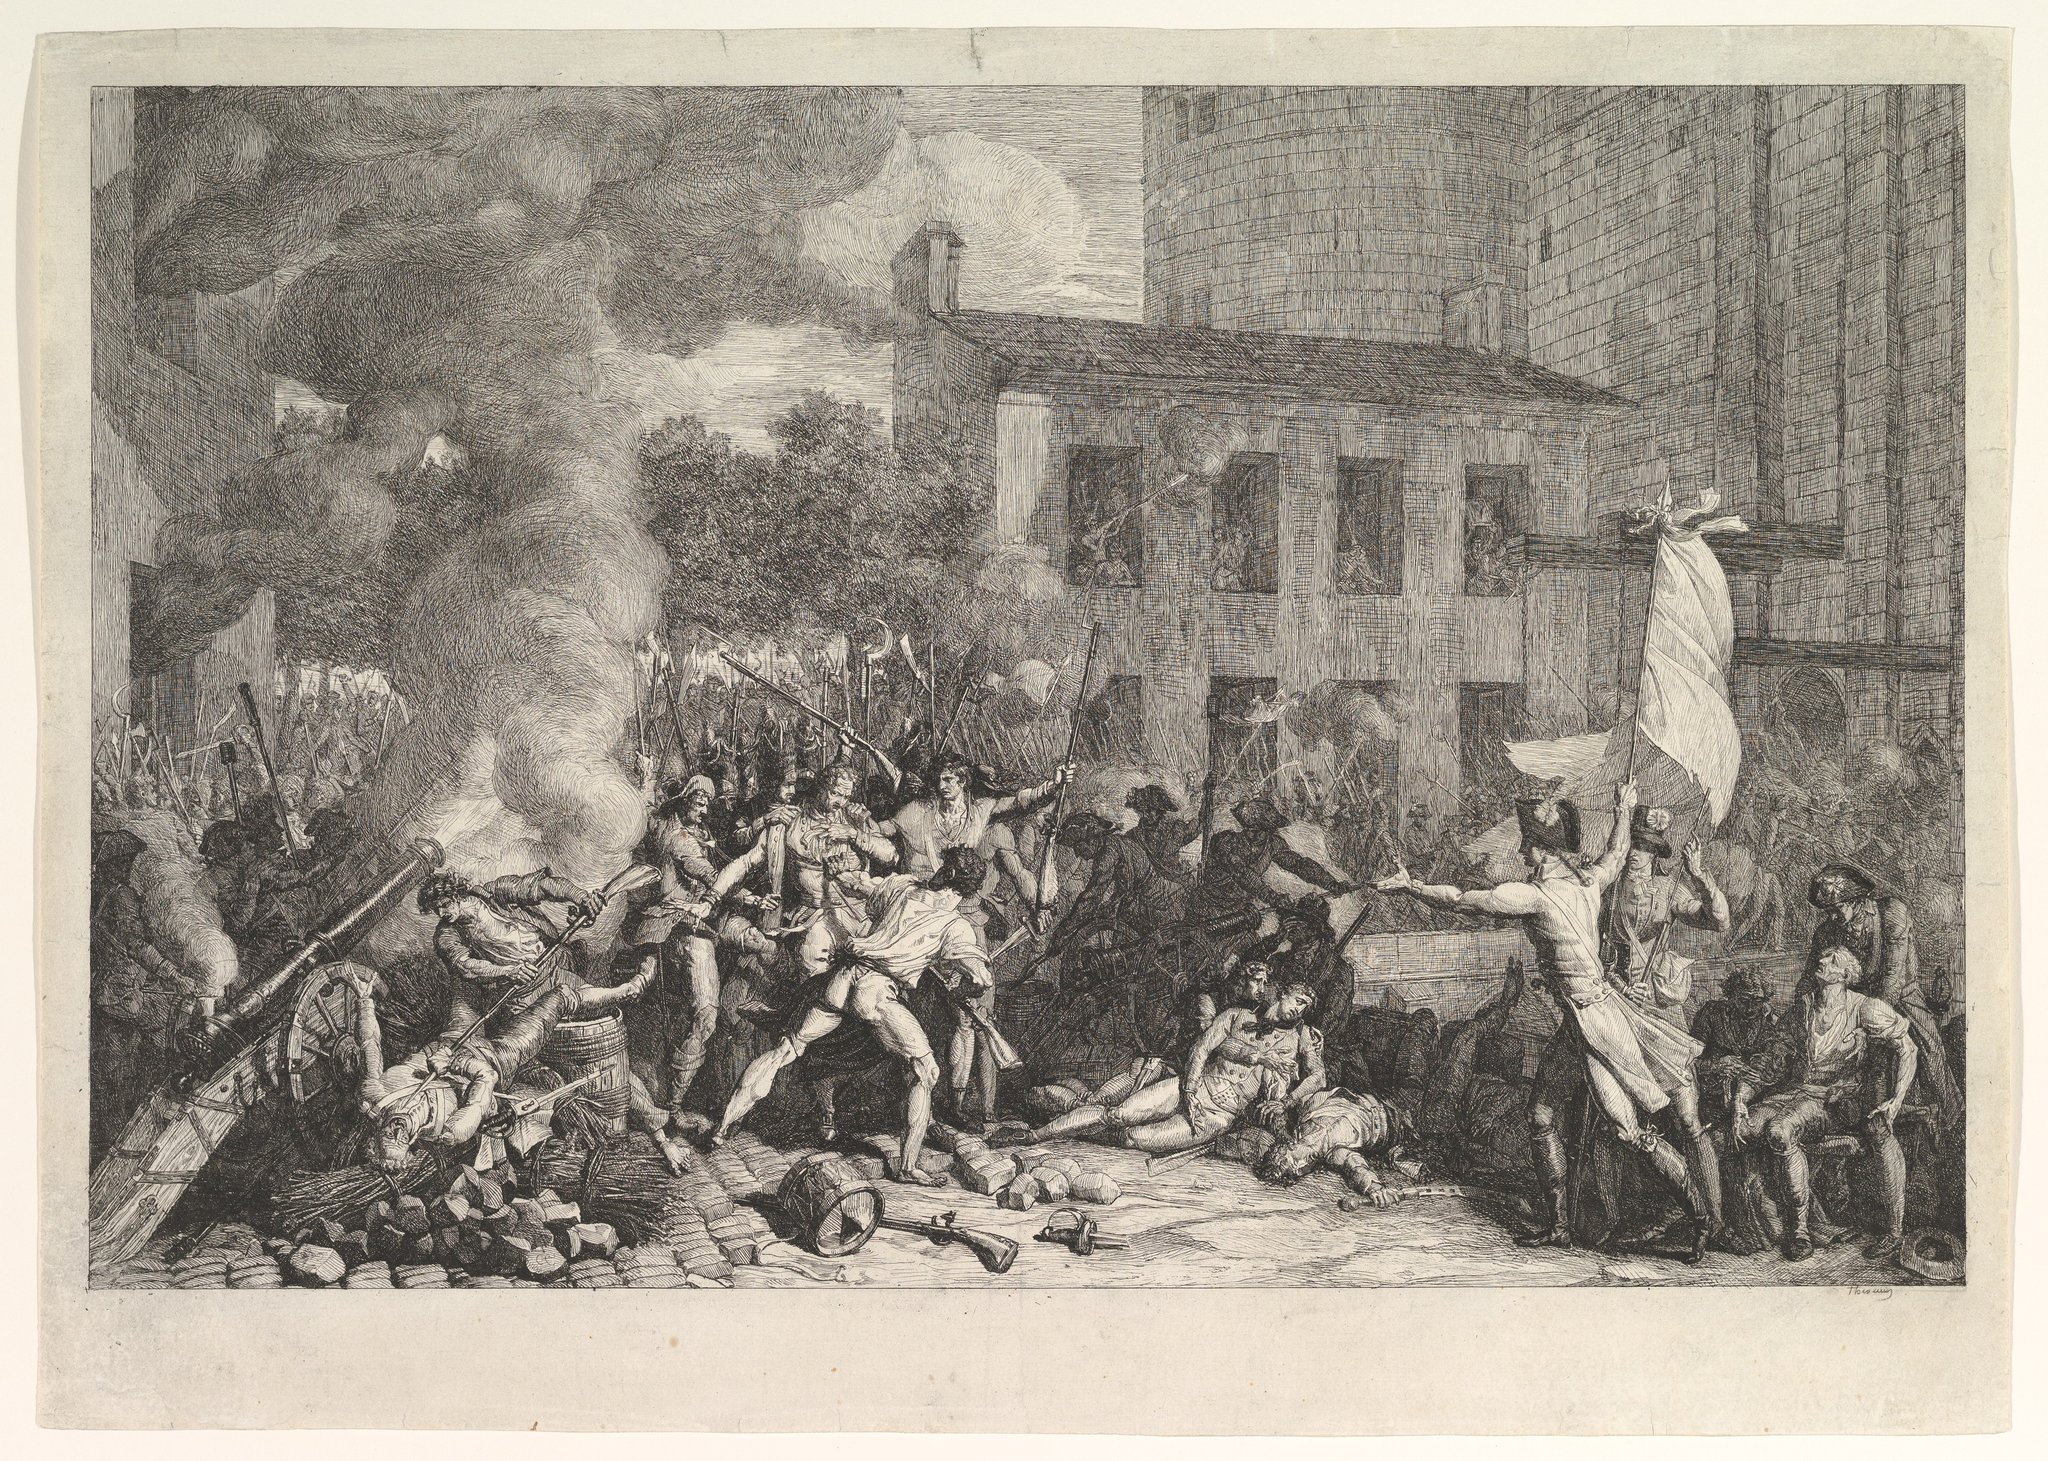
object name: print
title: The Storming of the Bastille on 14 July 1789 (Prise de la Bastille le 14 juillet 1789)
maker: charles thévenin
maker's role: artist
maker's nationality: french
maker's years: 1760-1839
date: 1793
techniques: etching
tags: prisons,soldiers,prisoners,firearms,flags